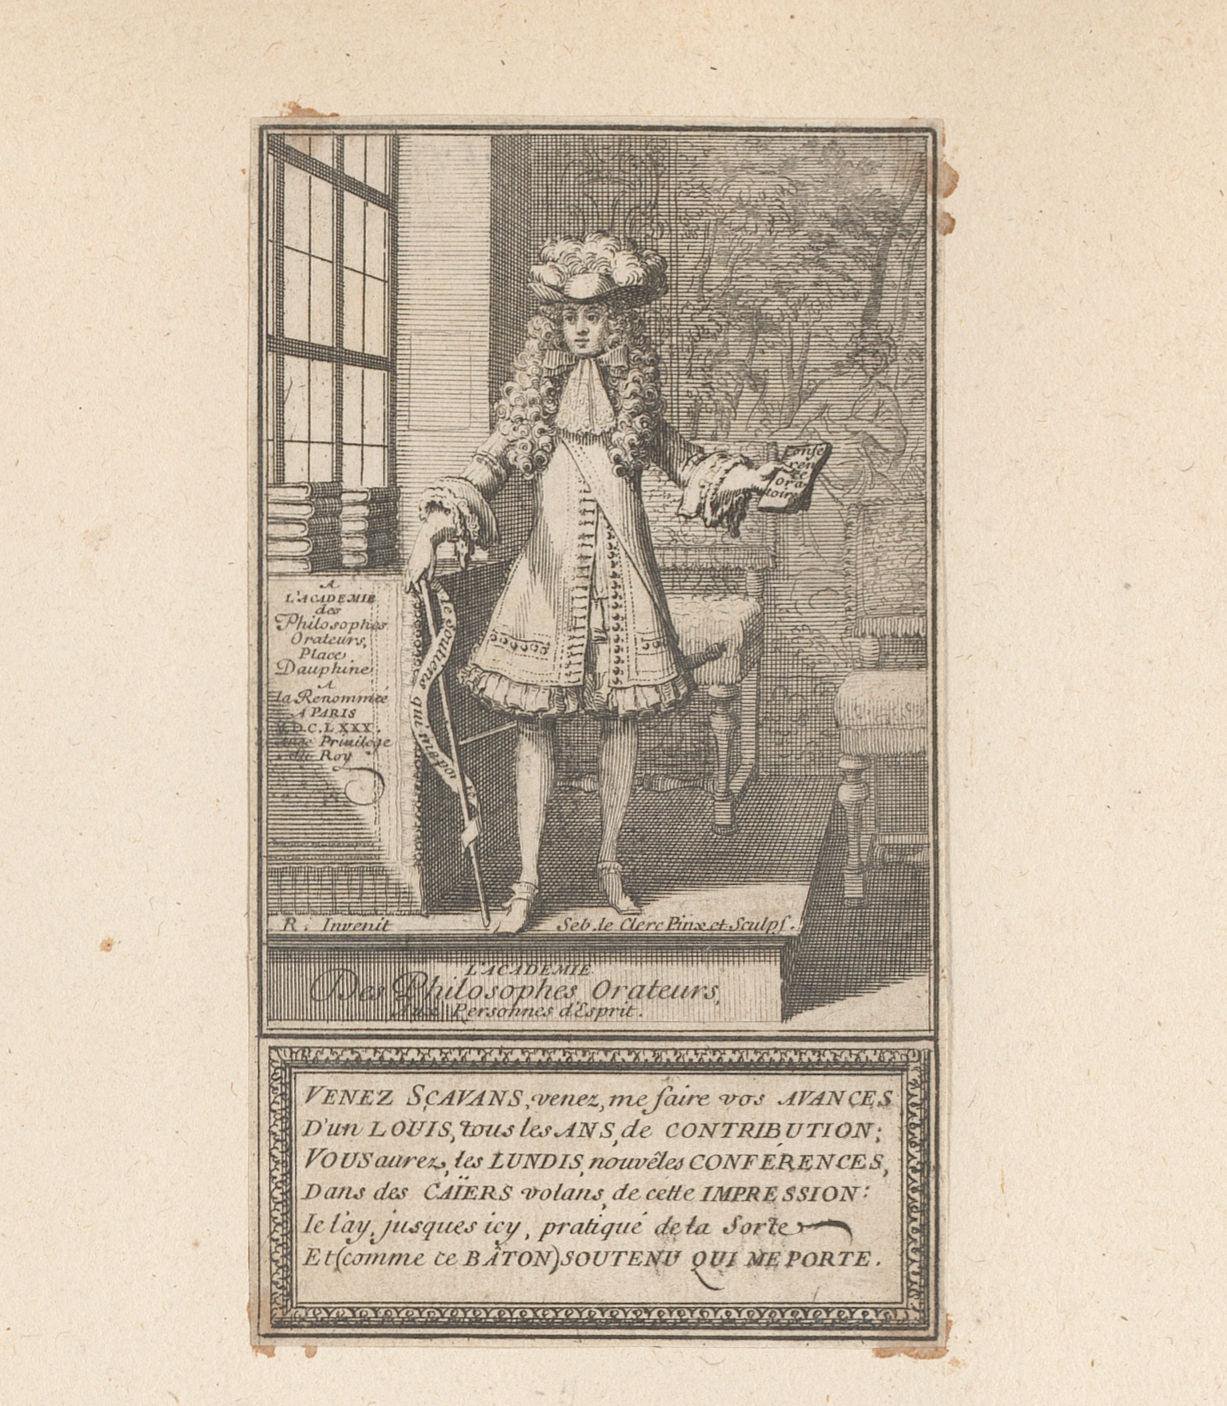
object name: print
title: Titelpagina voor: Oudart de Richesource, Quatorze problemes choisis (...), 1686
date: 1680-1686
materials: paper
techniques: etching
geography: paris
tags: title-page, interior of the house, tapestry, nobility and patriciate; chivalry, knighthood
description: Titelpagina voor: Richesource, Oudart de. Quatorze problemes choisis des onze volumes de conferences academiques et oratoires (...). Parijs: s.n., 1686.